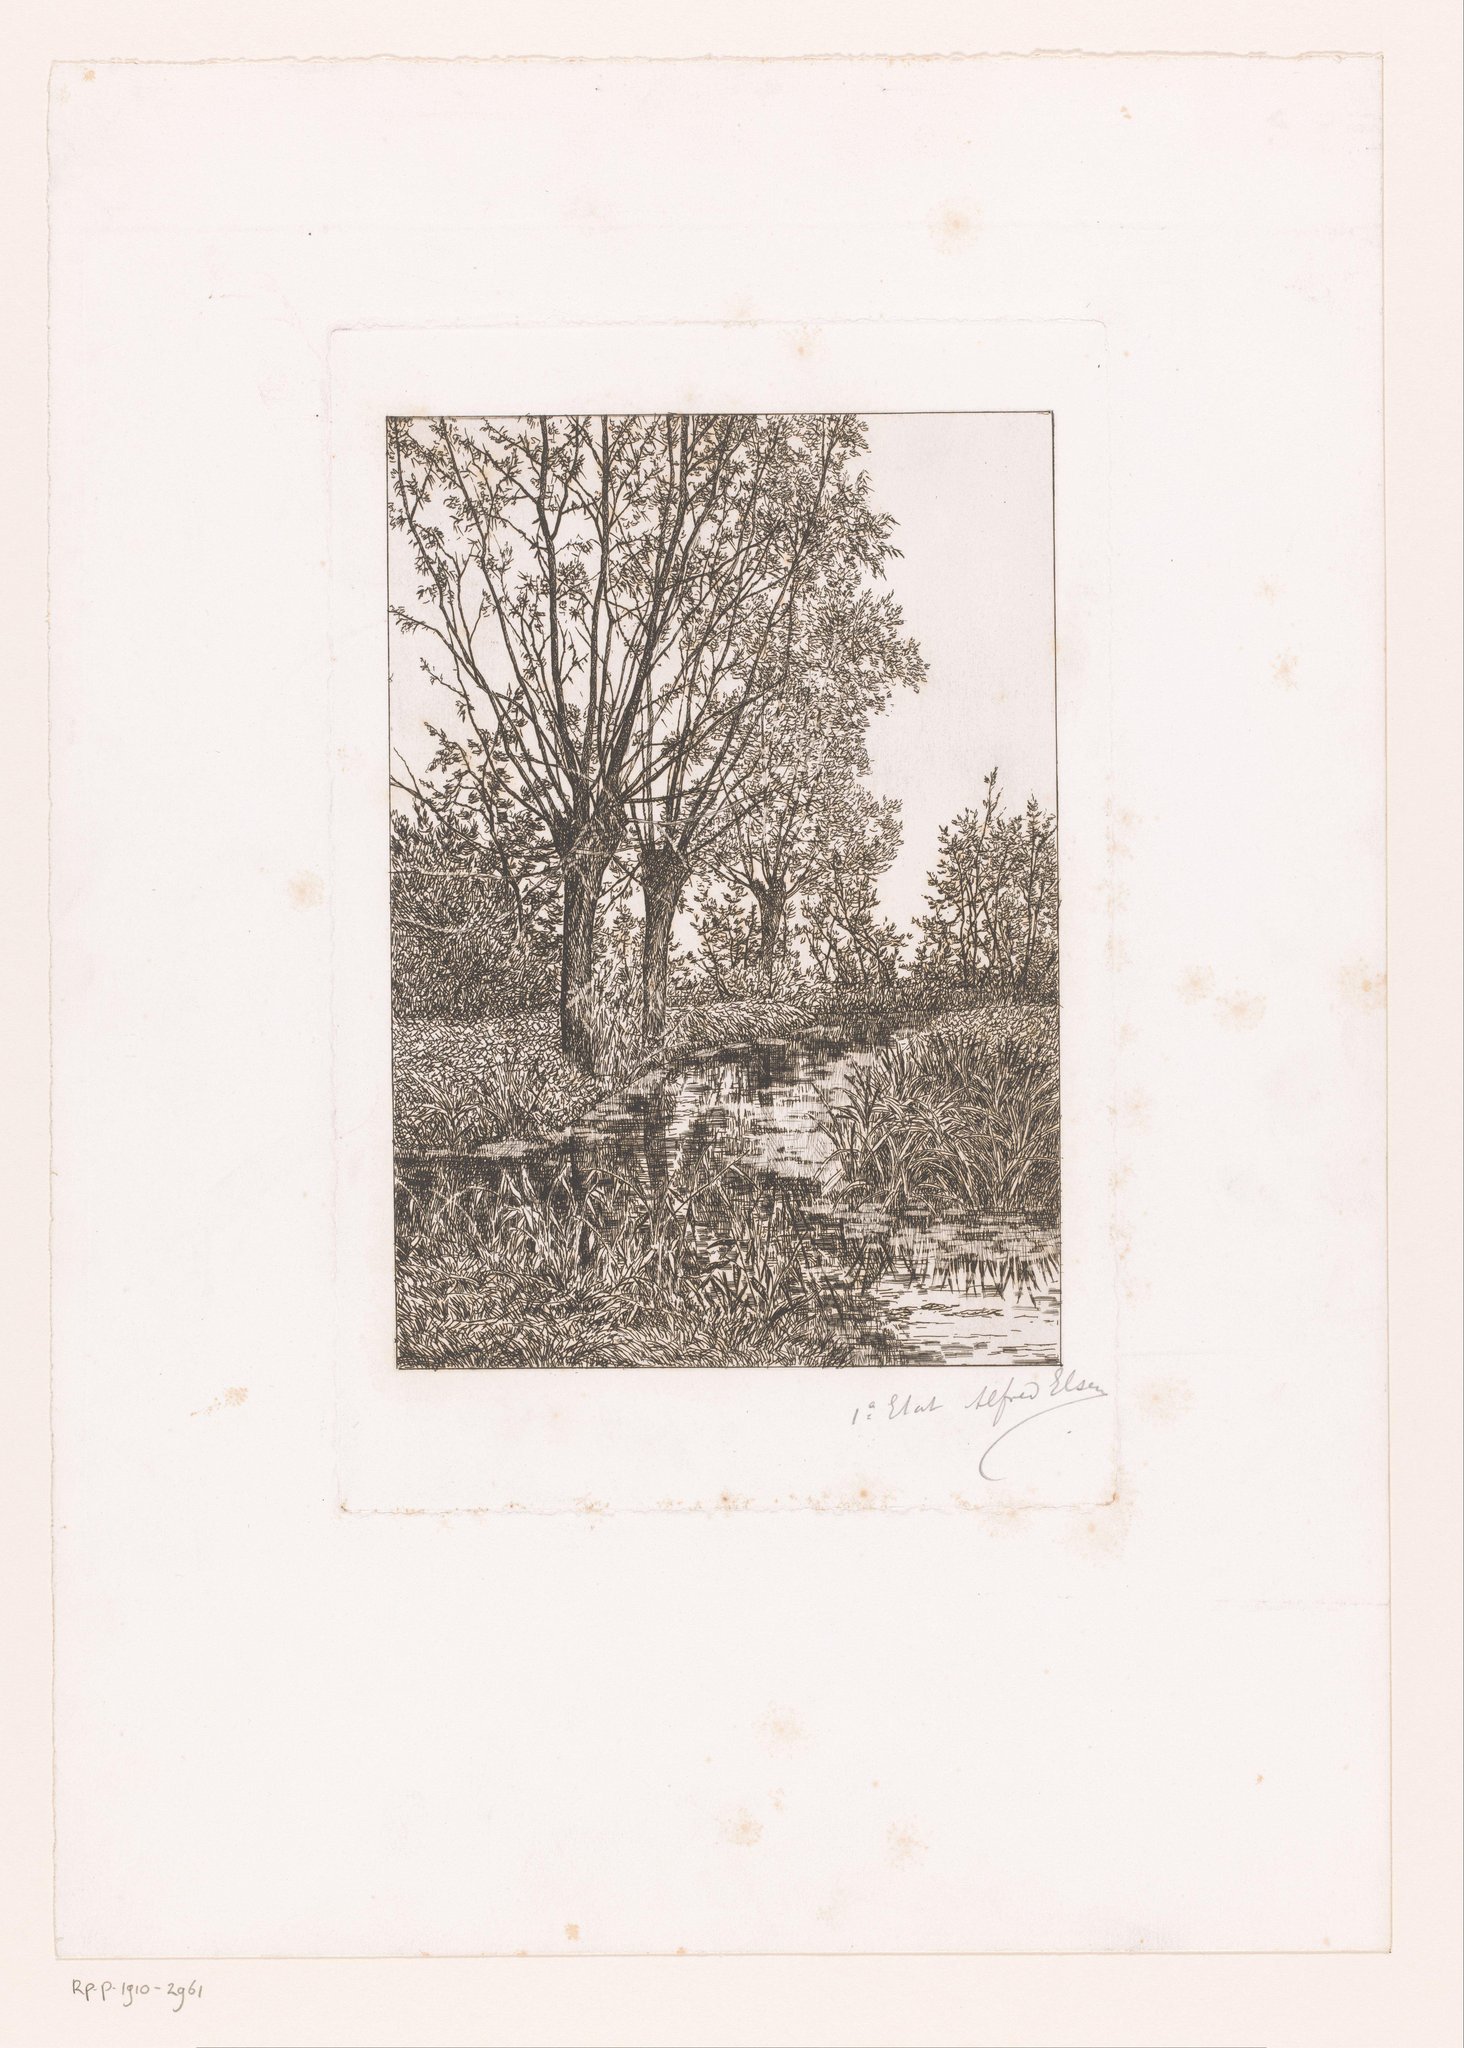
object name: print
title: Landschap met drie wilgen langs het water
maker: alfred elsen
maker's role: painter, print maker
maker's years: 1850-1914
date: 1860-1910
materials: paper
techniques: etching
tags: brook, trees: willow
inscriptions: inscription: ‘1e Etat’, collector's mark: Lugt 2228